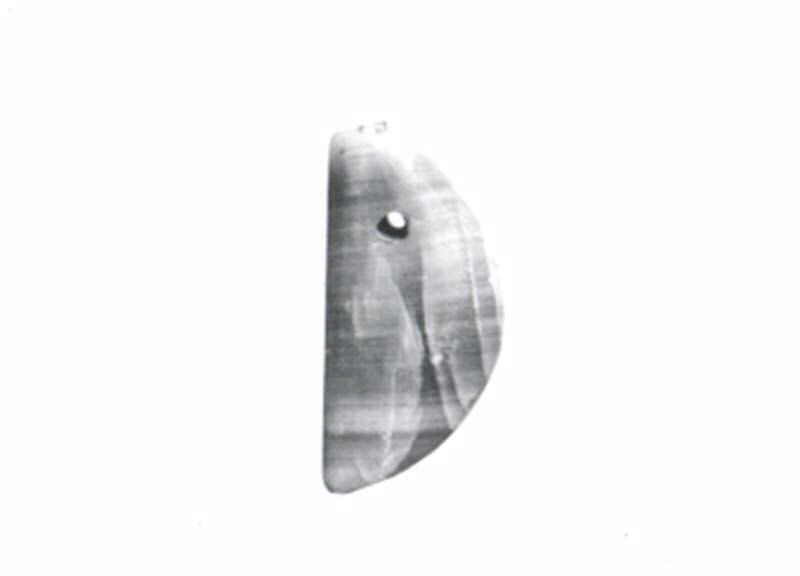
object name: pendant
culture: sasanian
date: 201-700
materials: stone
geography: iran